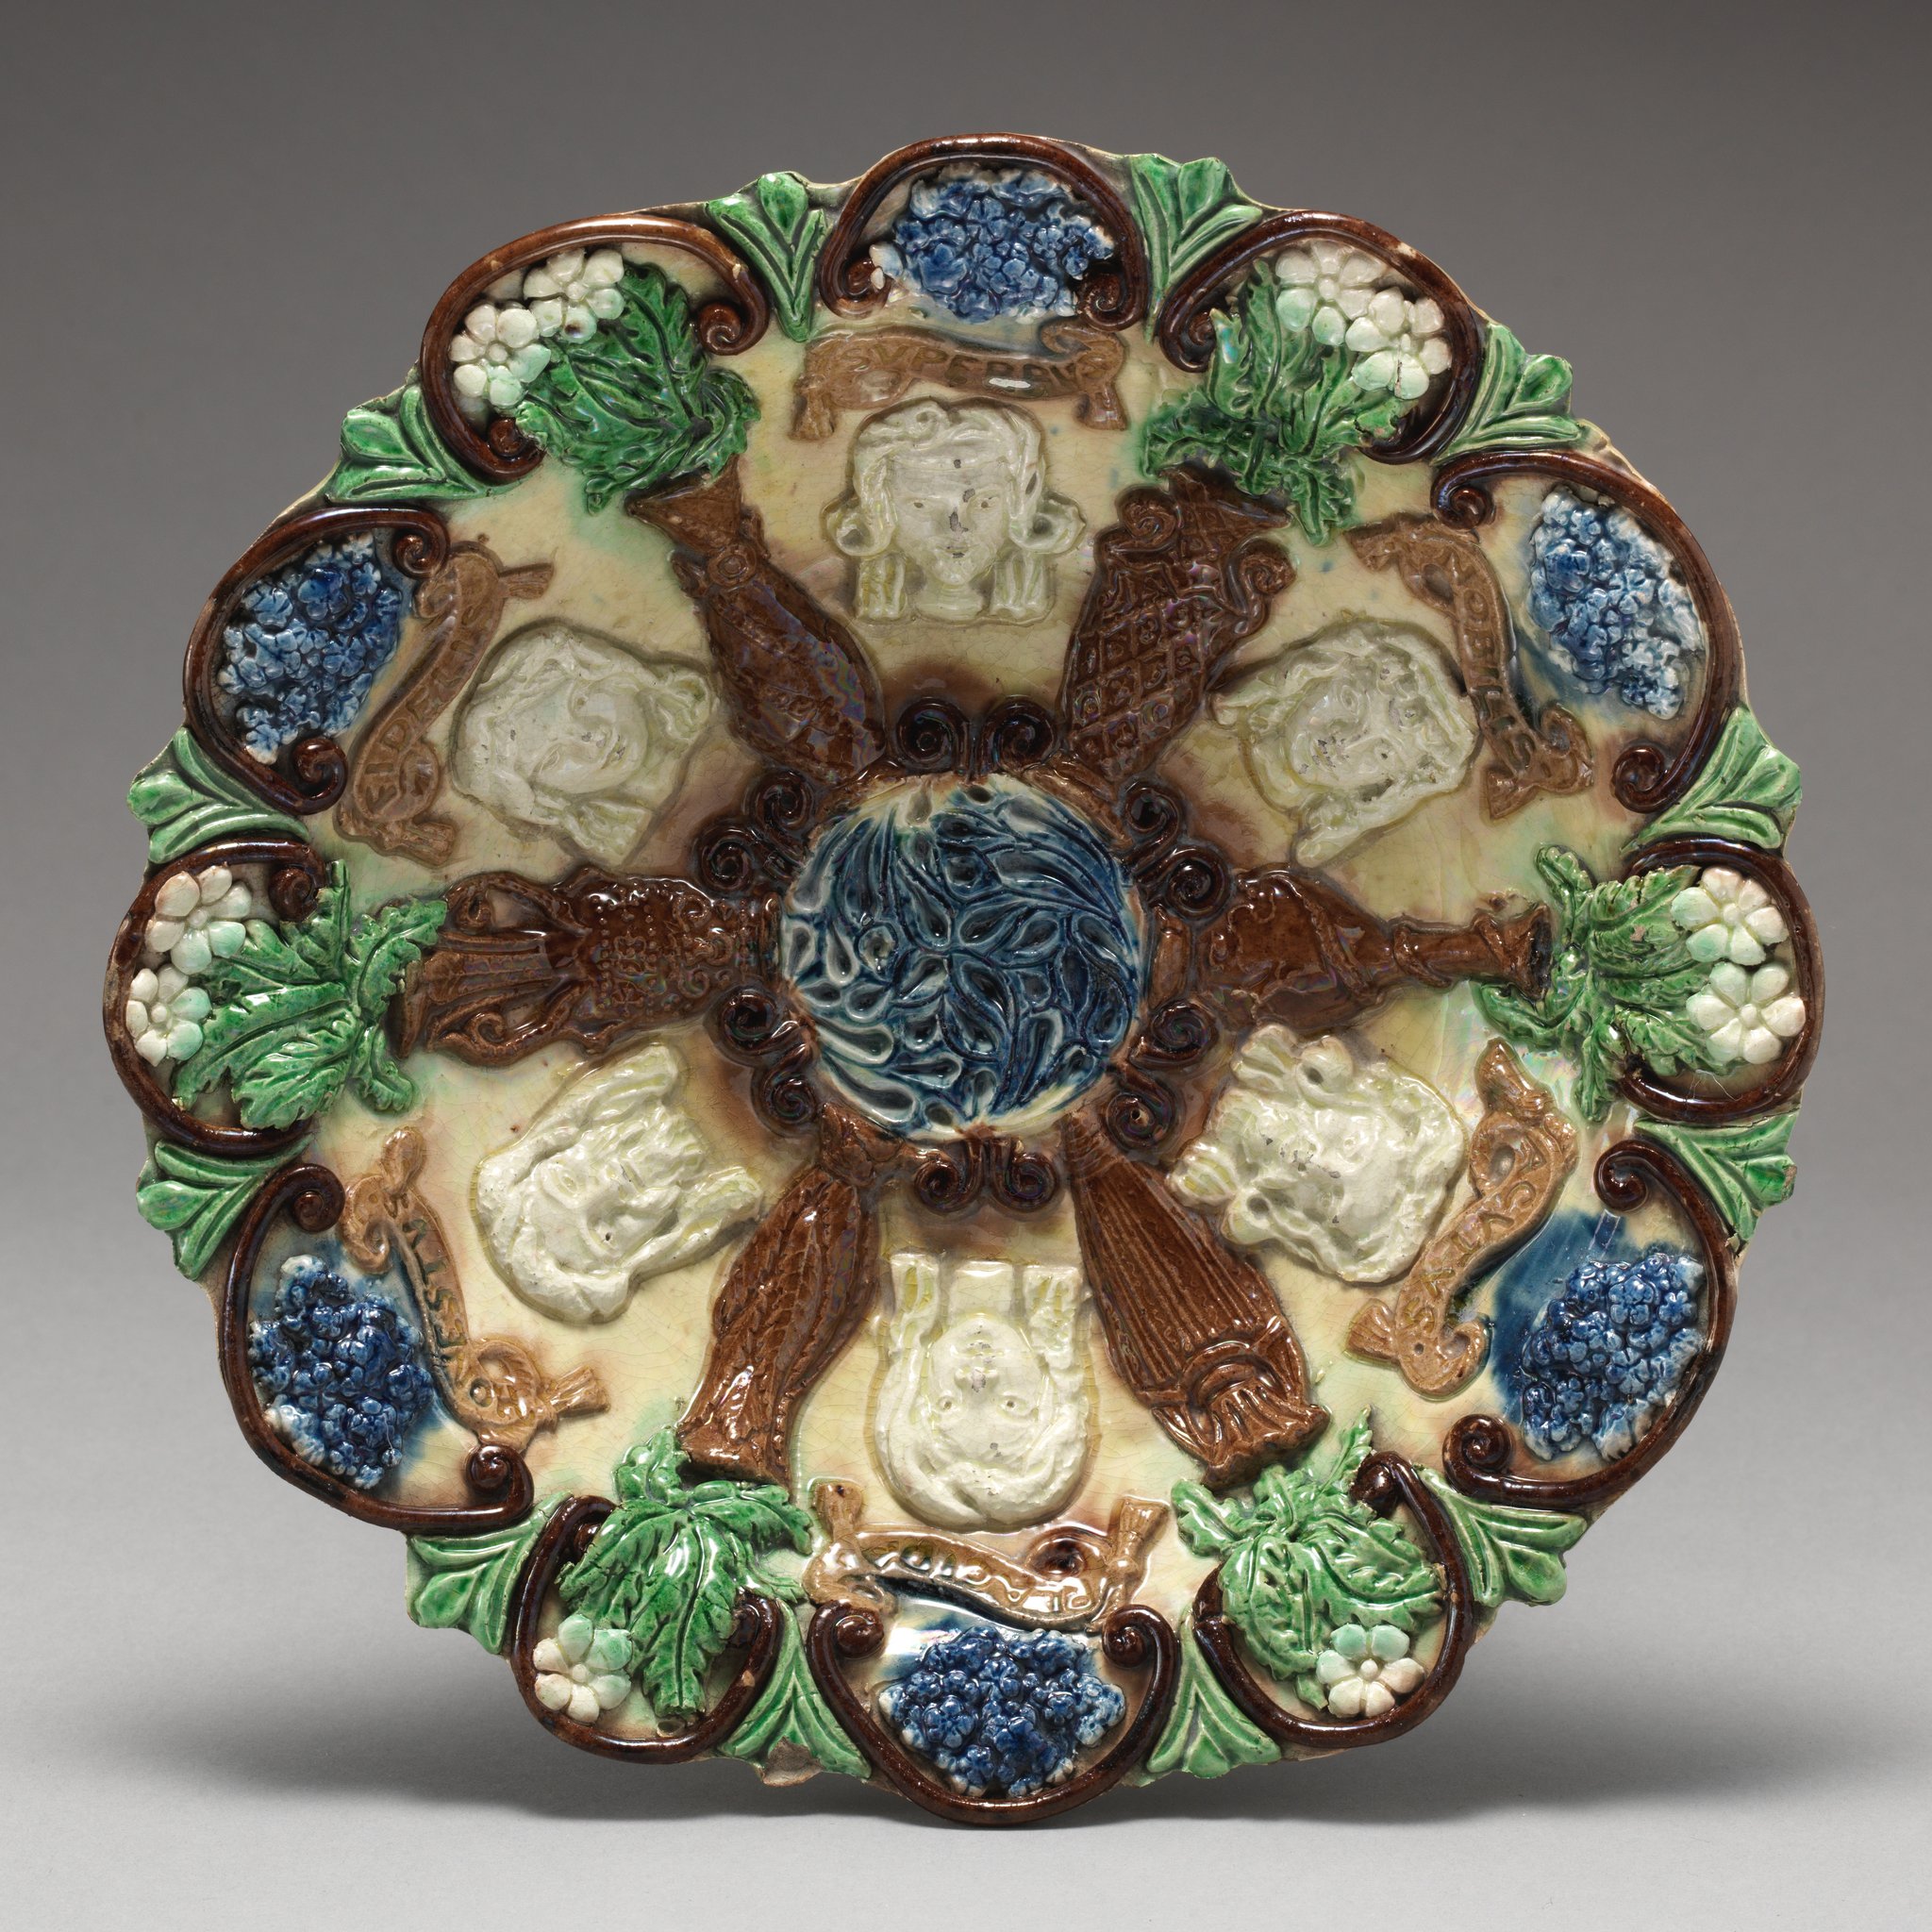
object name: plate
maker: castle hedingham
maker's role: factory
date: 1860-1885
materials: pottery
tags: faces,flowers